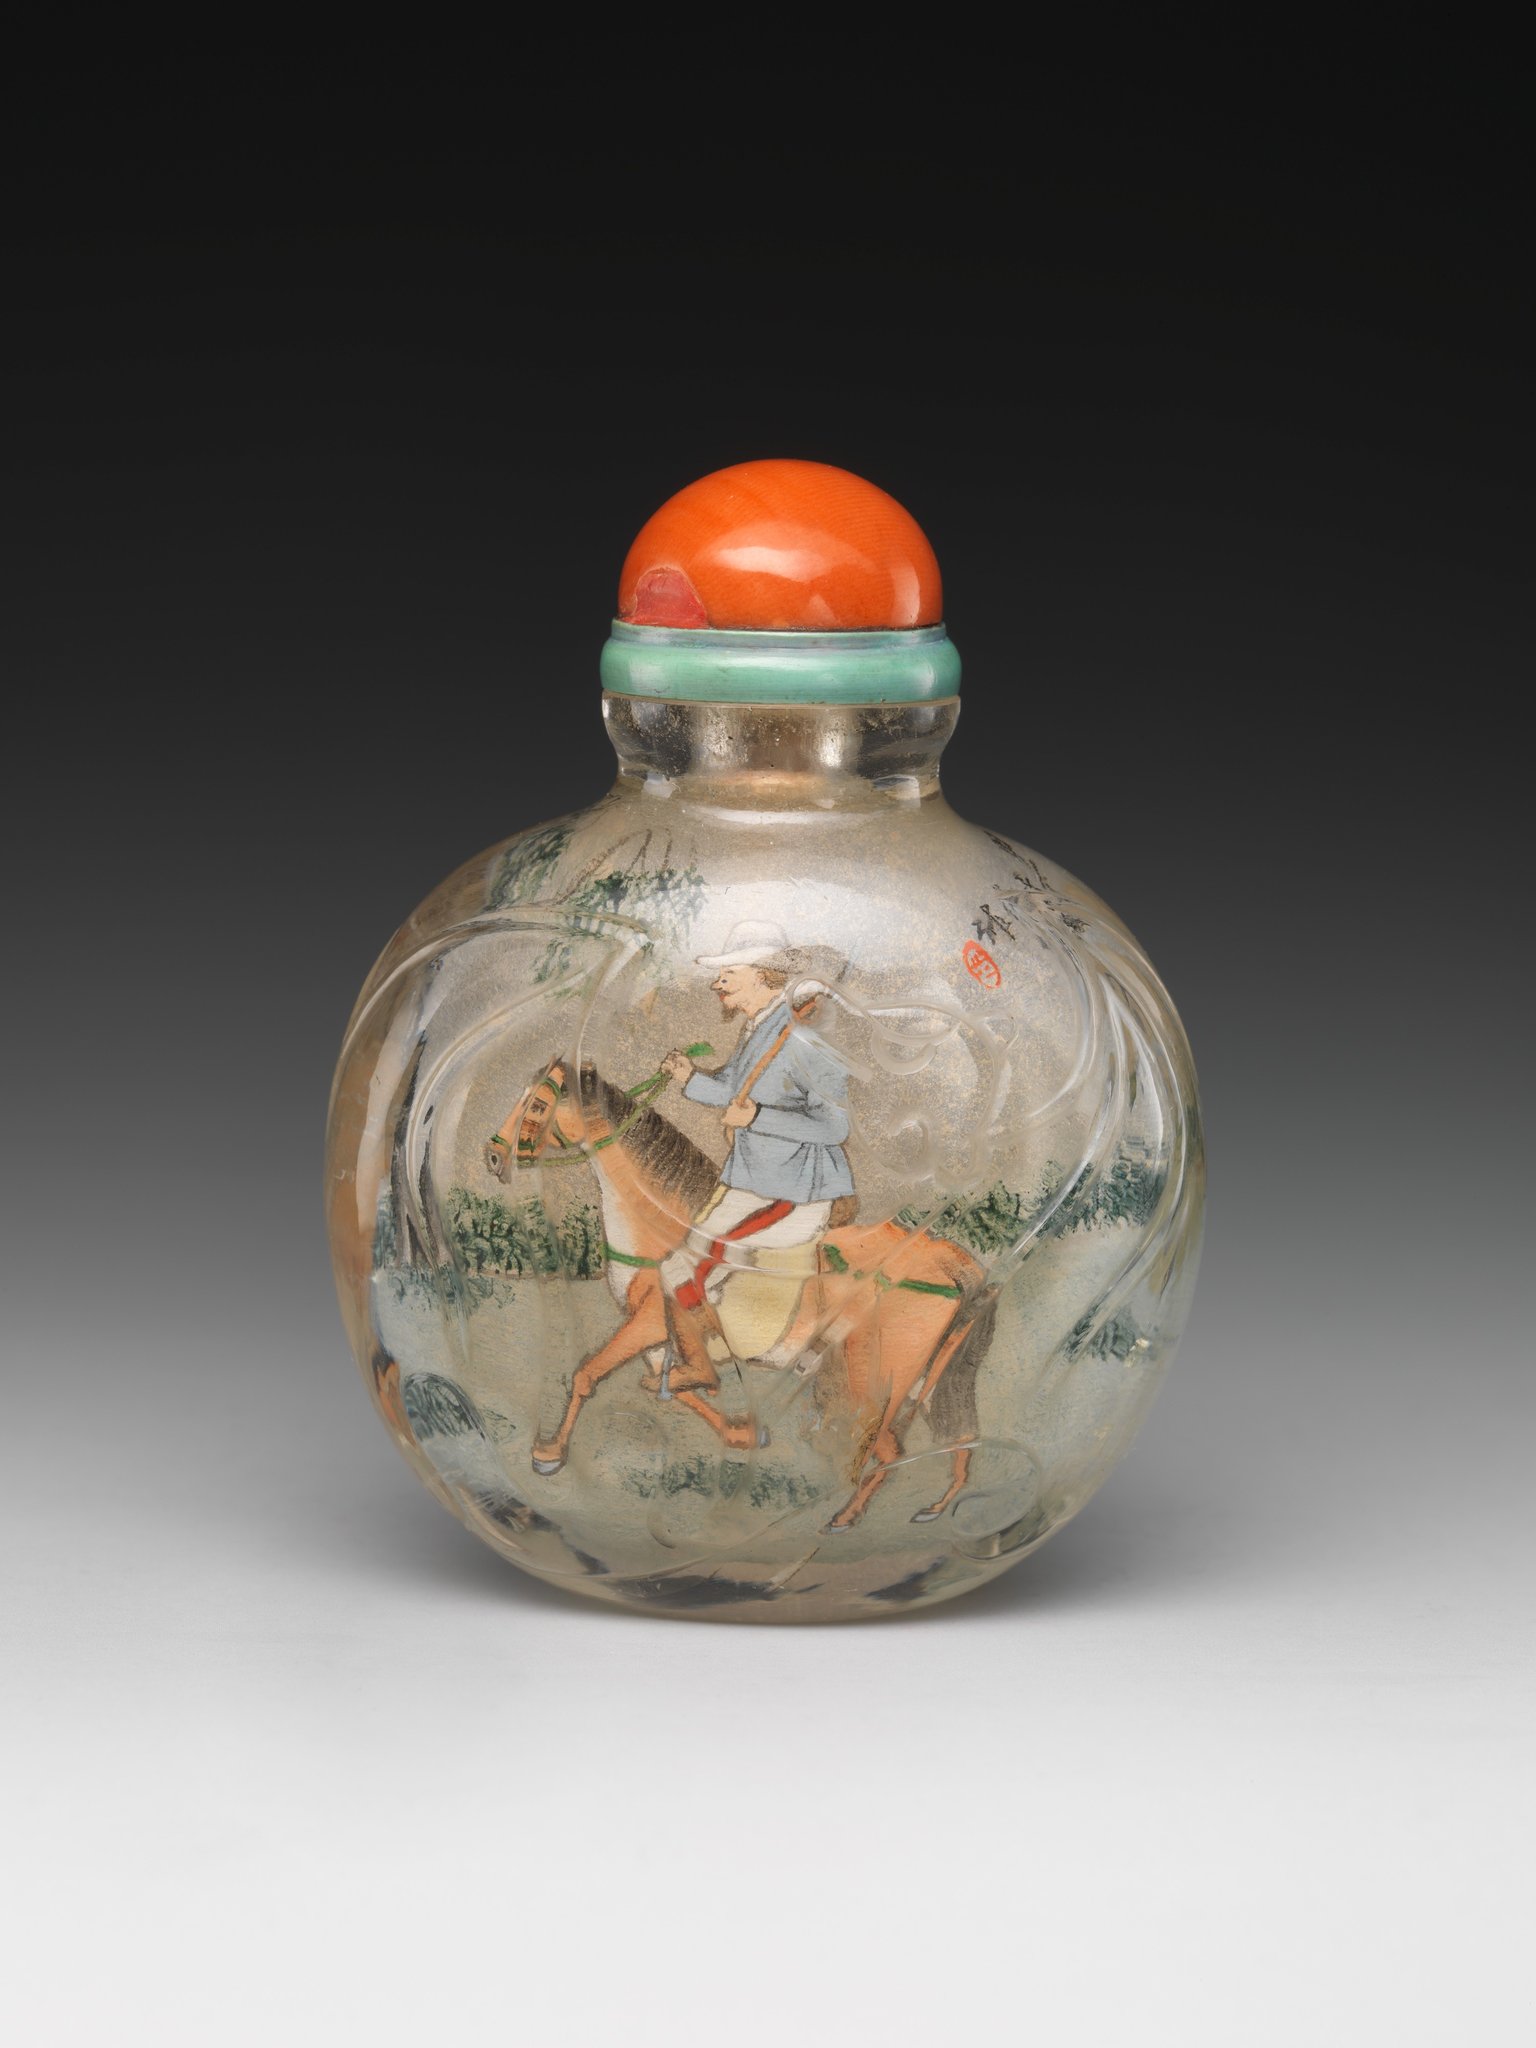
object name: snuff bottle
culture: chinese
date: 1736-1795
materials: coral, crystal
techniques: painting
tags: men,horses